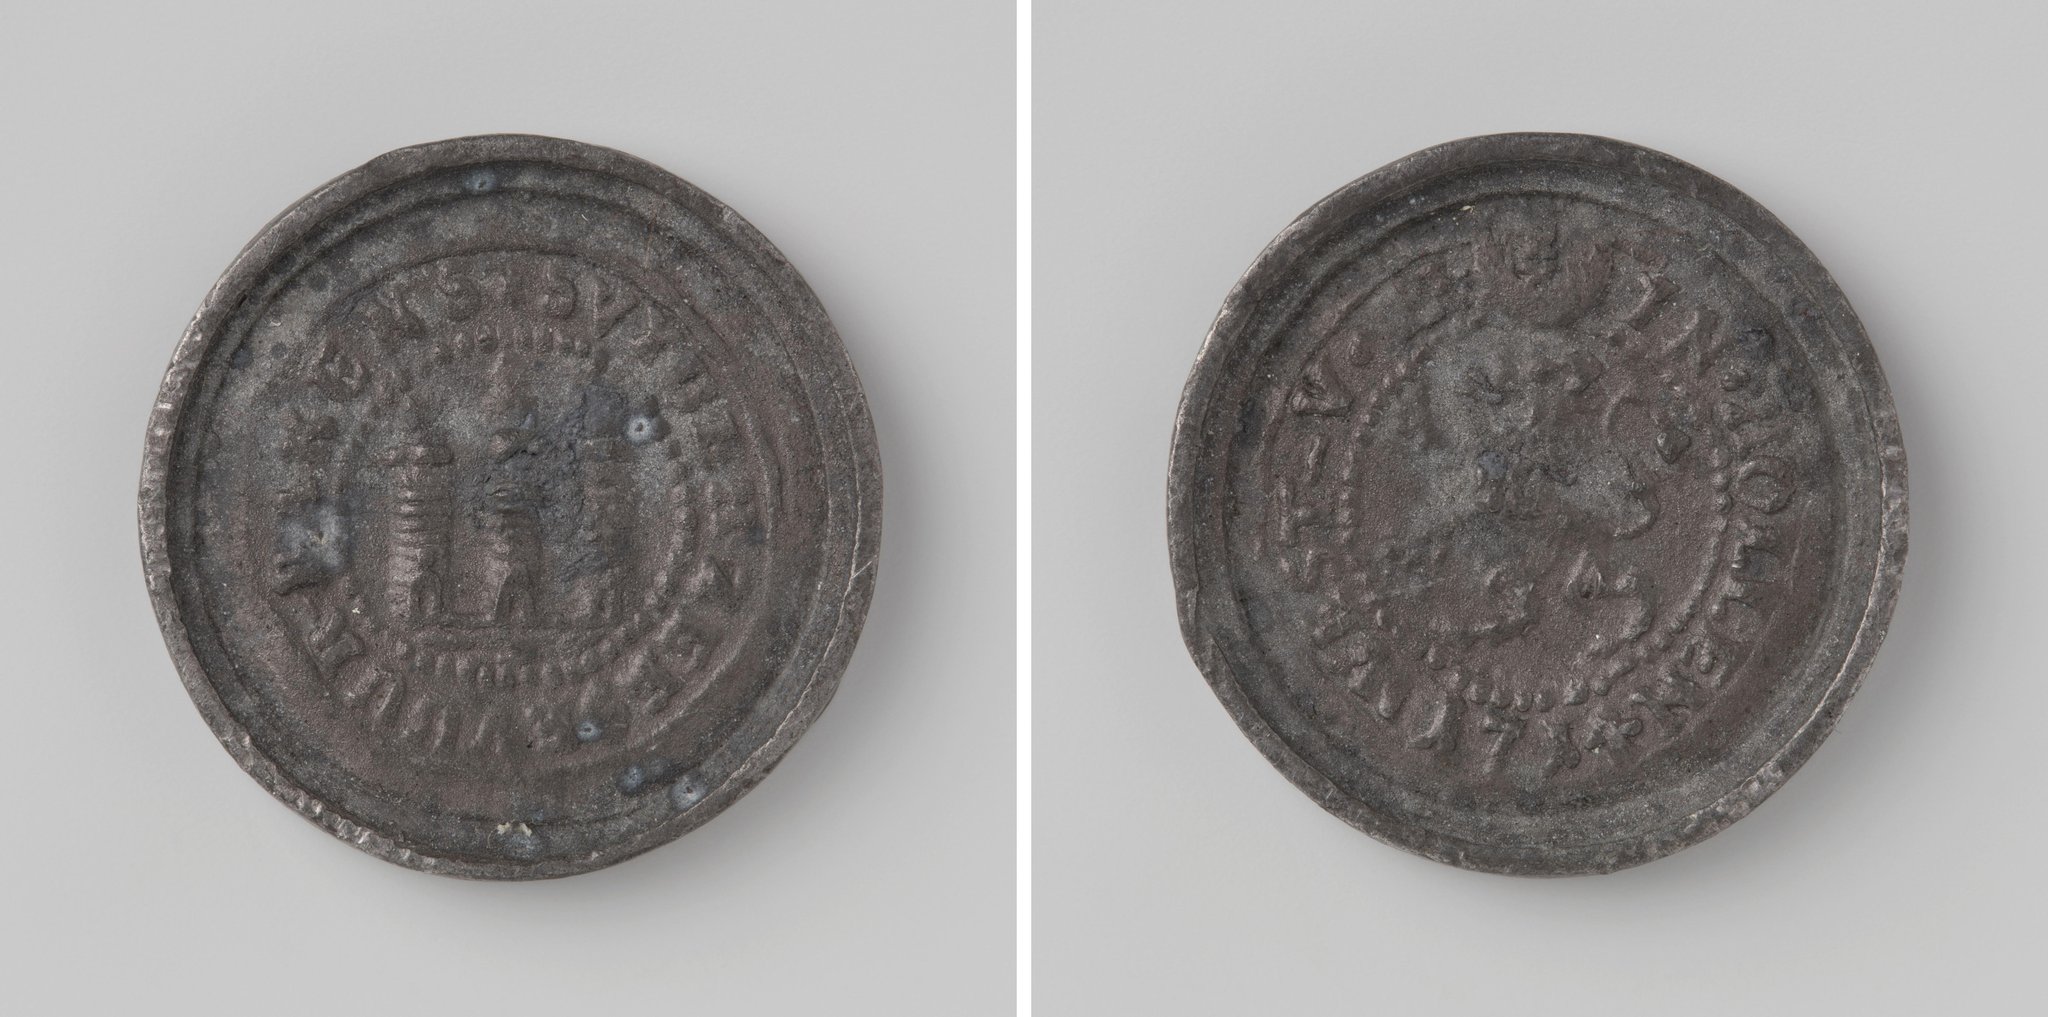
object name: tax token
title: Bewijs van betaalde belasting (bakengeld) voor schepen onder de vijftig last, voor het in stand houden van de Vuurbakens aan de Zuiderzee.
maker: Anonymous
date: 1714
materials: lead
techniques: striking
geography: netherlands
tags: amsterdam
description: Loodje met verhoogde rand. Voorzijde: drie vuurbakens, waarvan linker en rechter branden binnen omschrift. Keerzijde: leeuw onder wapenschild van Amsterdam binnen omschrift.